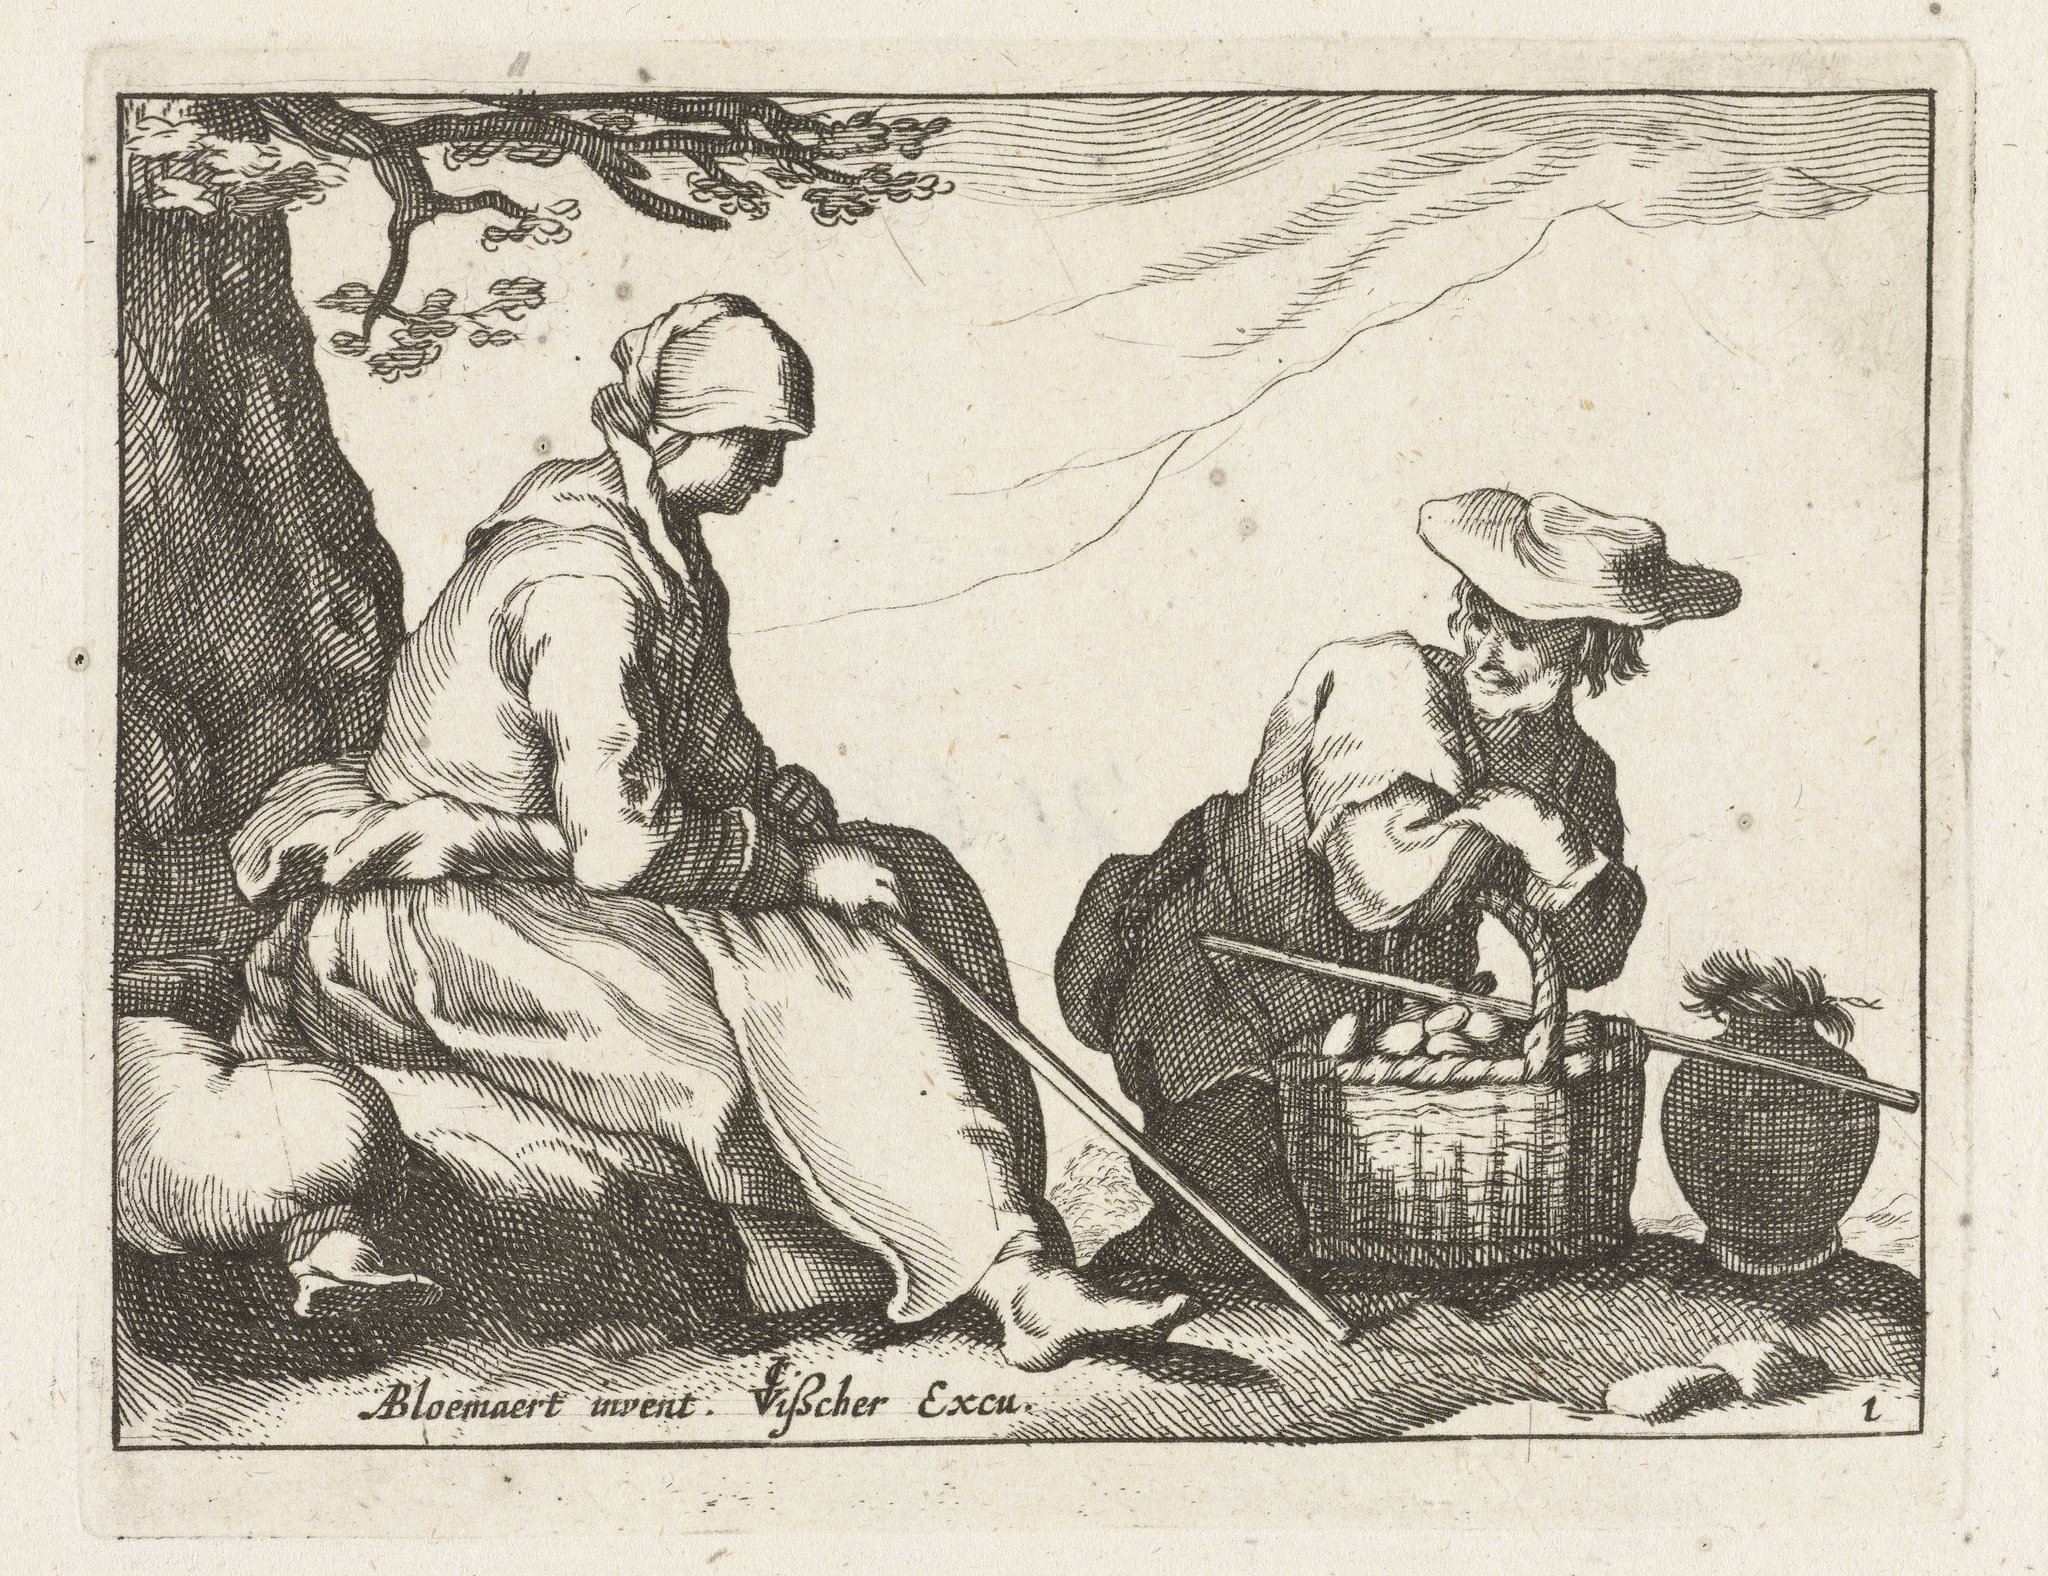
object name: print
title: Vrouw en man met mand met eieren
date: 1620-1670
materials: paper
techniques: engraving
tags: herding, herdsman, herdswoman, shepherd, shepherdess, cowherd, etc., eggs, egg-dishes, lovers; courting, flirting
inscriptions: collector's mark: Lugt 2233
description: Kopie naar prent van Boëtius Adamsz. Bolswert. Bolswert vervaardigde zijn originele serie met vier genre scènes naar ontwerp van Abraham Bloemaert. De tekeningen van Bloemaert dateren uit de jaren twintig van de zeventiende eeuw en Bolswert graveerde pas jaren later deze voorstellingen (Roethlisberger 1993, p. 244).